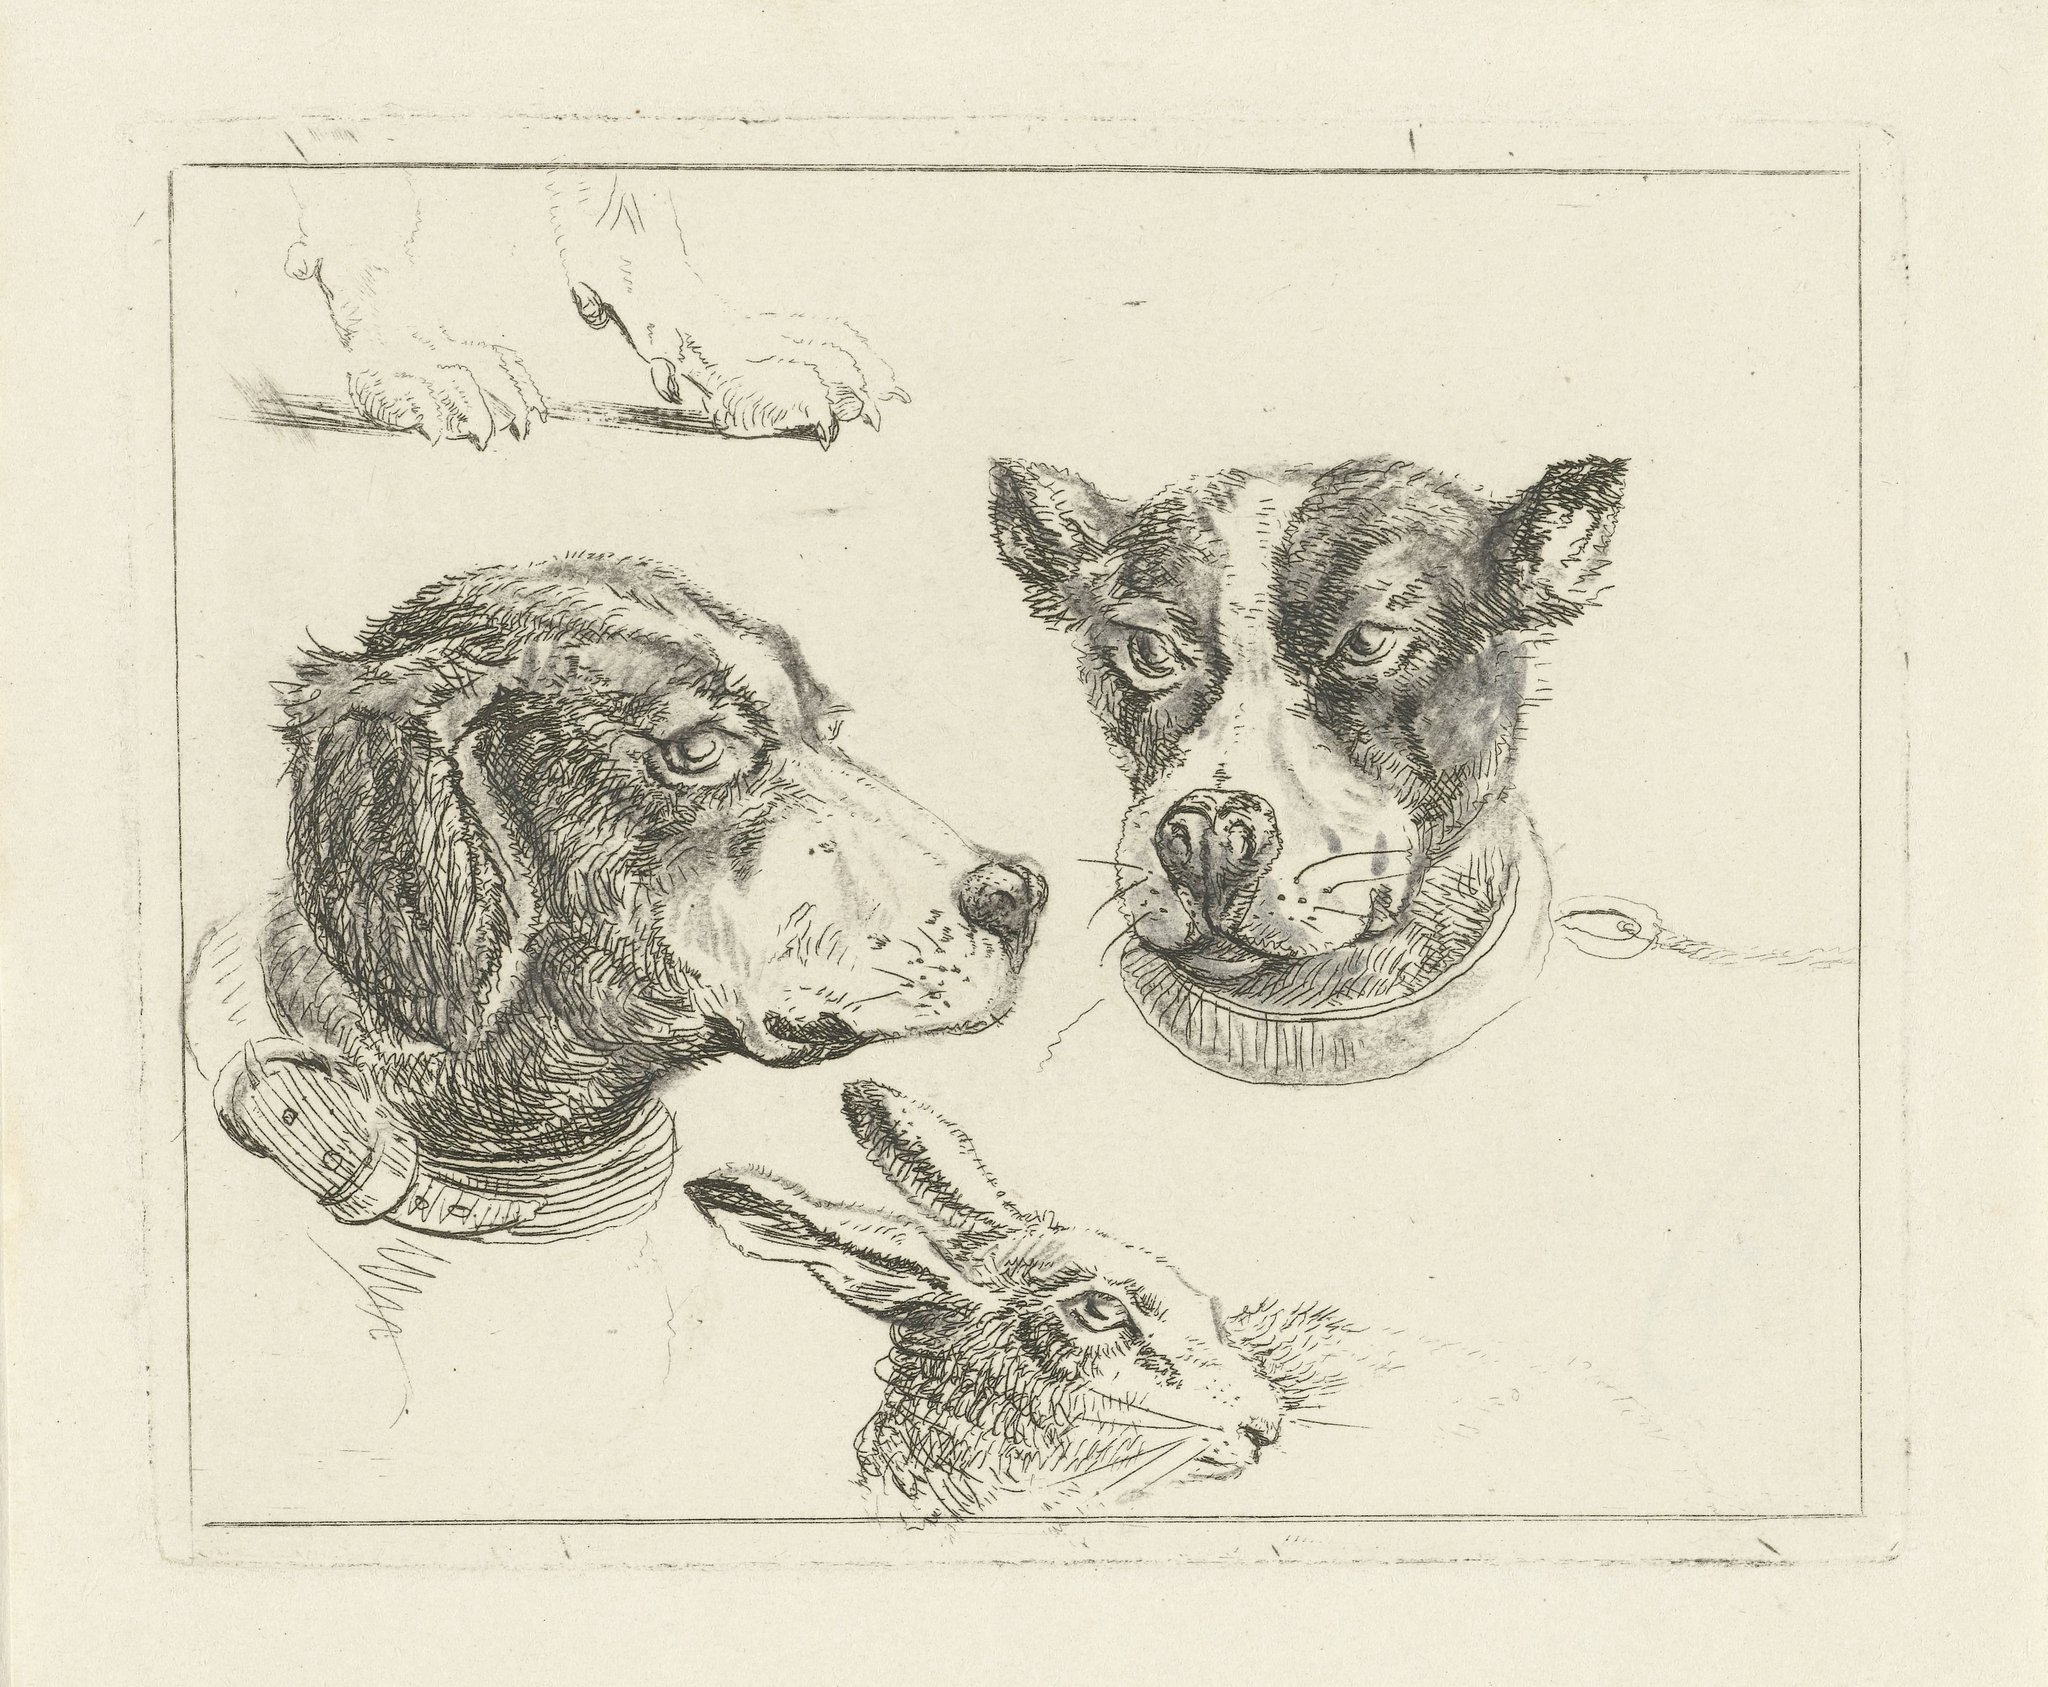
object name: print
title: Studieblad met twee hondenkoppen, poten van hond en kop van haas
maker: jan dasveldt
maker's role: draughtsman, print maker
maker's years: 1770-1855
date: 1780-1855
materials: chalk, paper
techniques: etching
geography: amsterdam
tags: rodents: hare, dog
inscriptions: collector's mark: Lugt 2228